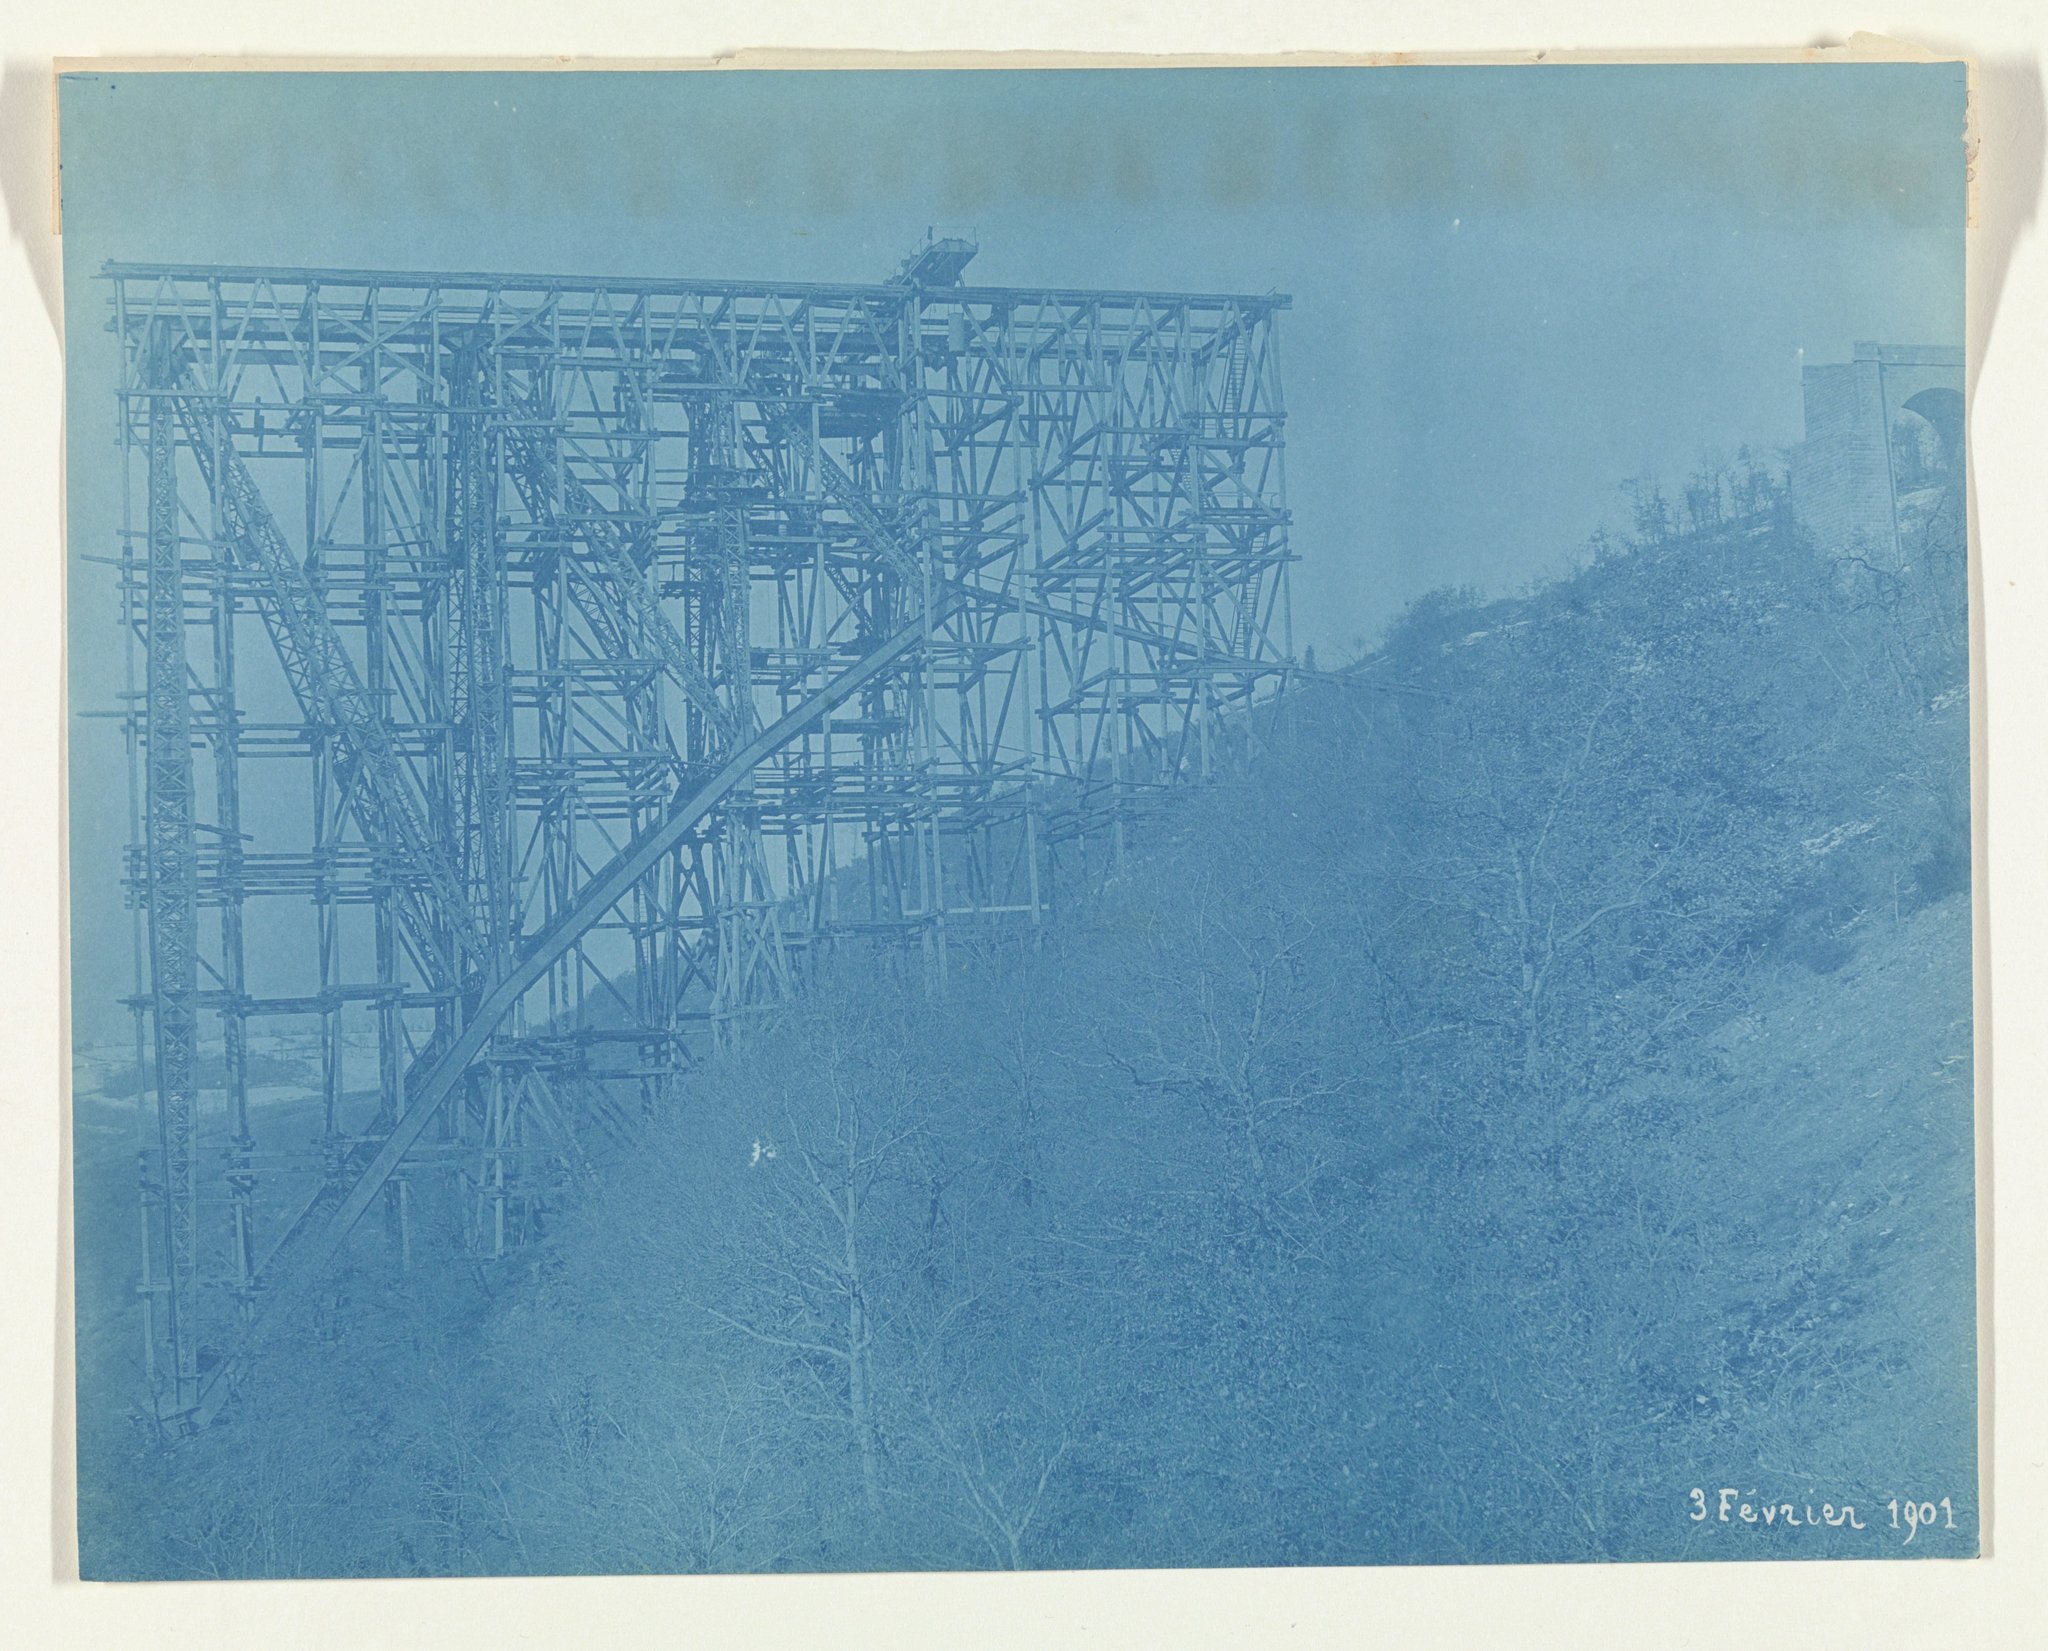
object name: photograph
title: Aanleg van het Viaur Viaduct in Frankrijk door de Societé de Construction des Battignolles, 3 febrauri 1901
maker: Anonymous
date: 1901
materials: photographic support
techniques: cyanotype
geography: france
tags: viaduct, making the overground structures (~ building activities)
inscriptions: date